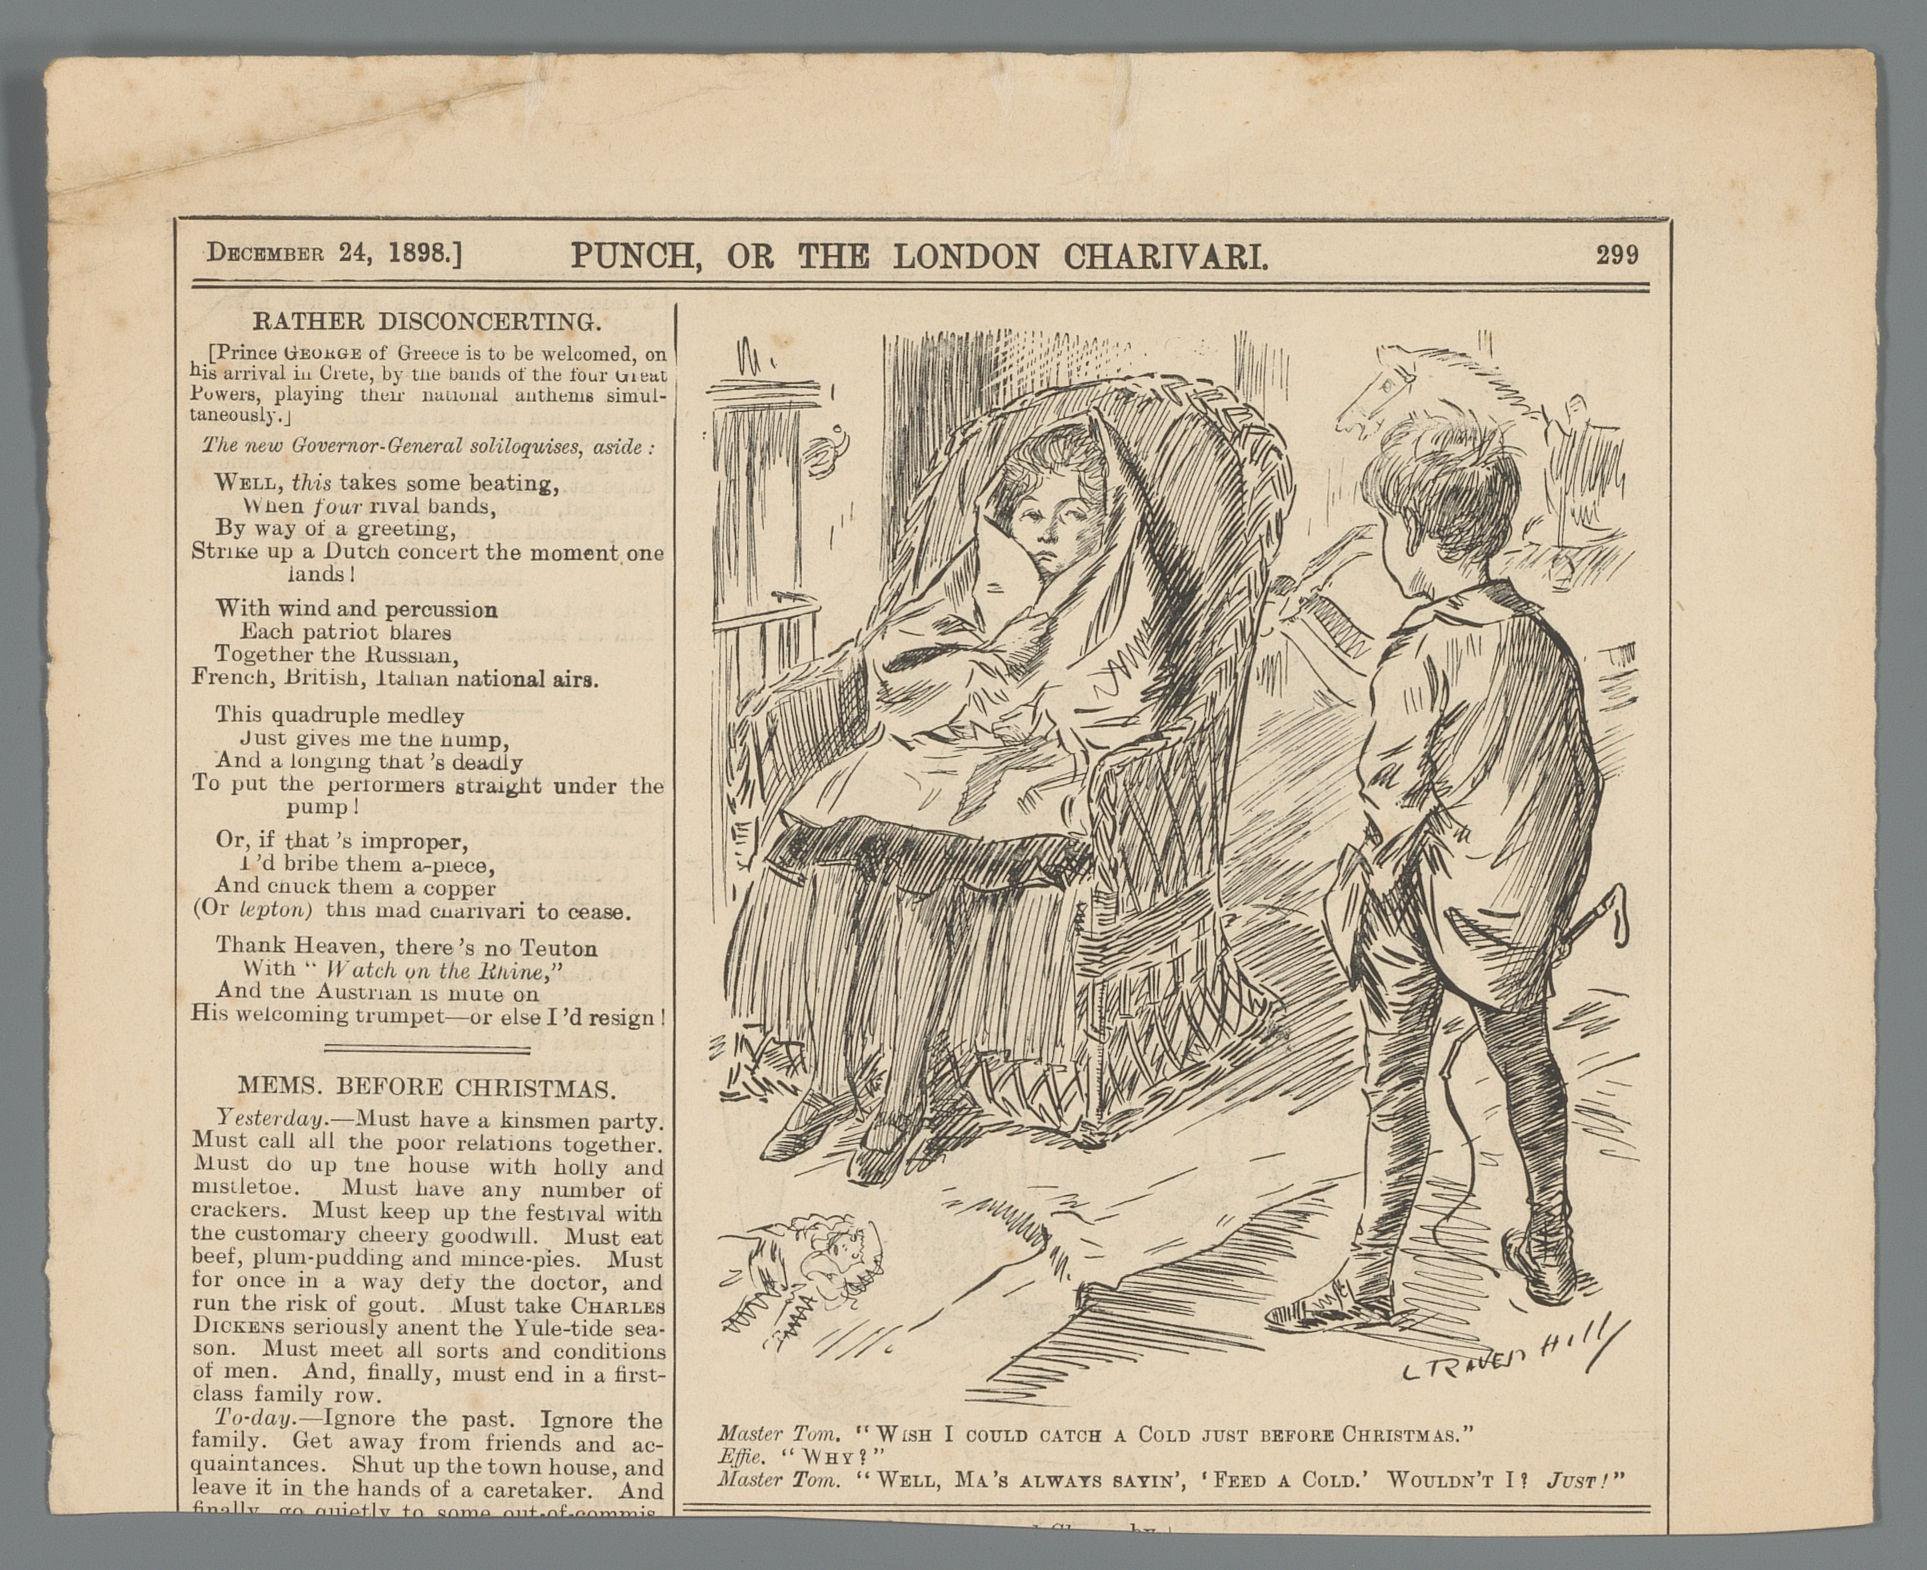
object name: cartoon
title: Jongen met zieke zusje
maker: leonard raven-hill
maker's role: draughtsman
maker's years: 1867-1942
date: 1898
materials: paper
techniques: line block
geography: england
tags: christmas (non-liturgical celebration), sick-bed, political caricatures and satires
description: Jongetje is jaloers op zijn zusje die ziek is met kerstmis. Spotprent uit het Engelse satirische tijdschrift Punch, 24 december 1898, p. 299.